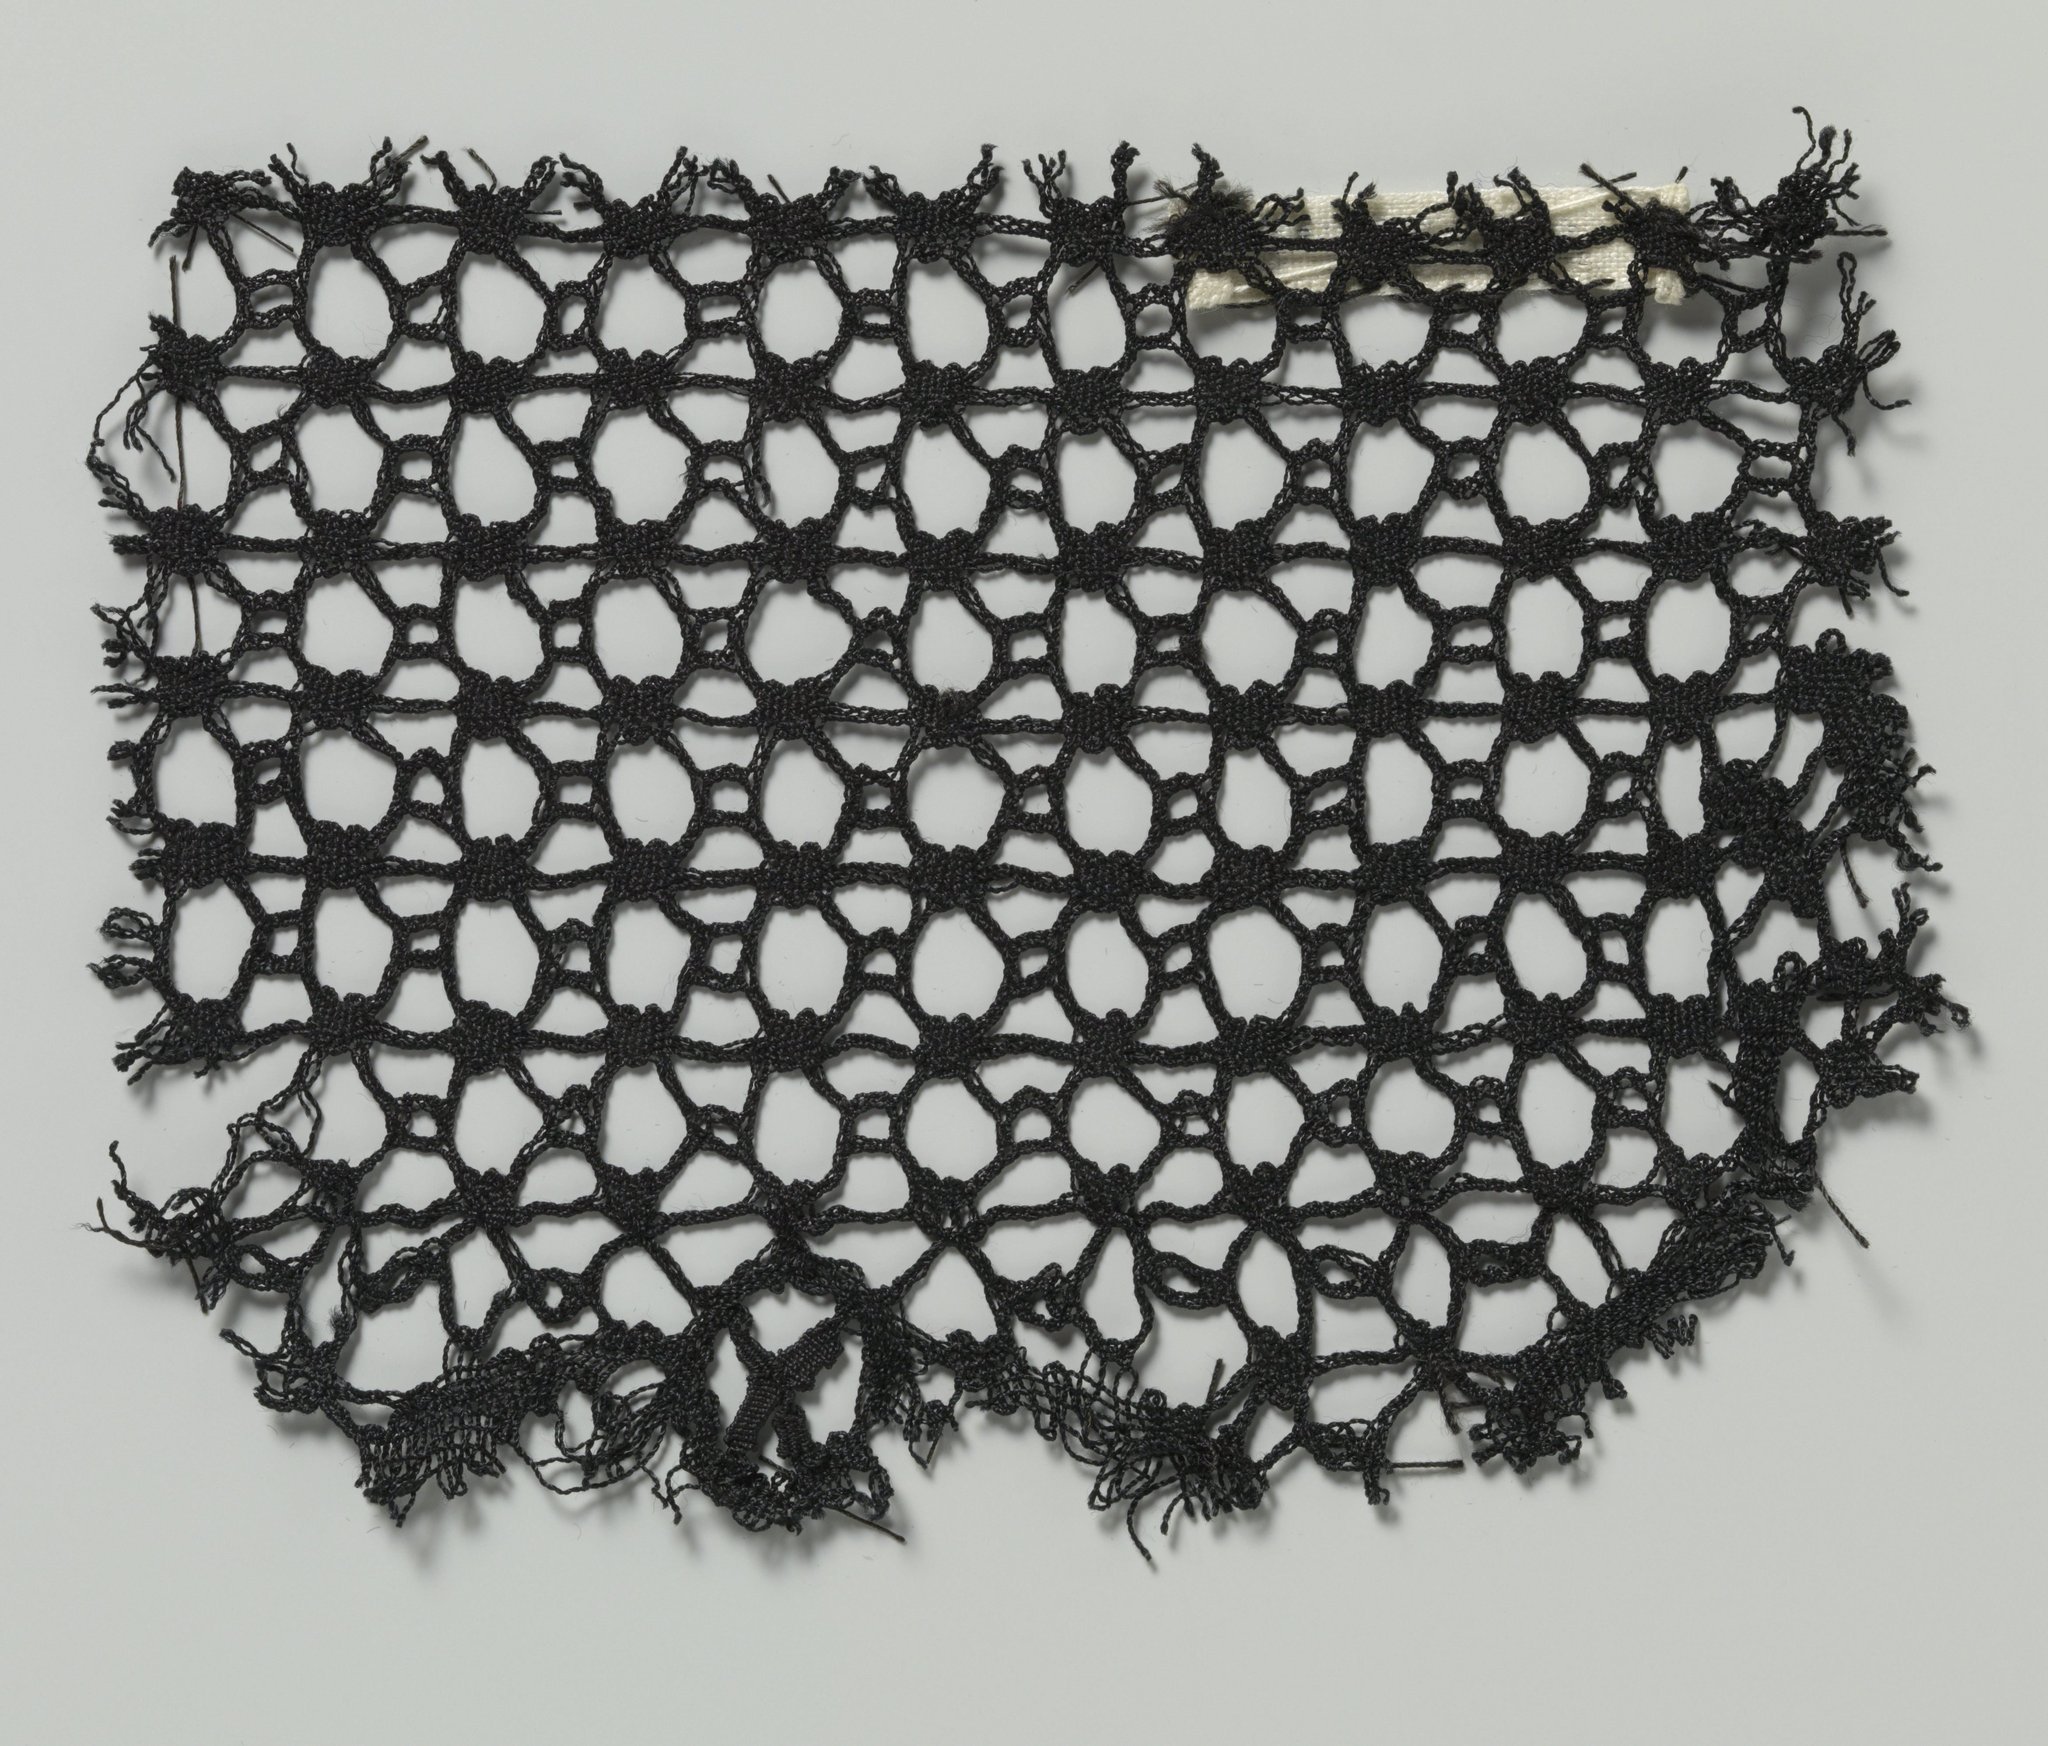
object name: fragment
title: Fragment kloskant met kruisjes tussen zeven horizontale lijnen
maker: Anonymous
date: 1875-1899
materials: silk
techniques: lace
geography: cluny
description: Fragment zwarte kloskant, Cluny-kant. Het betreft een rechthoekig fragment, dat aan alle zijden onafgewerkt is. Het fragment vertoont een siergrond met zeven dunne rechte lijnen, met op korte en regelmatige afstand min of meer hartvormige motiefjes. Tussen de rechte lijnen in worden deze motiefjes met elkaar verbonden door kruisjes tussen gebogen dwarslijntjes. In het centrum van elk kruisje staat een opengewerkt vierkantje. De rechte, gebogen en kruisende lijnen betreffen vlechtjes. De hartvormige motiefjes zijn gemaakt in linnenslag. Aan één van de langere zijden is een opgewerkte cirkel te zien, waarin in bladvormige vormslag een kruisje is gemaakt.